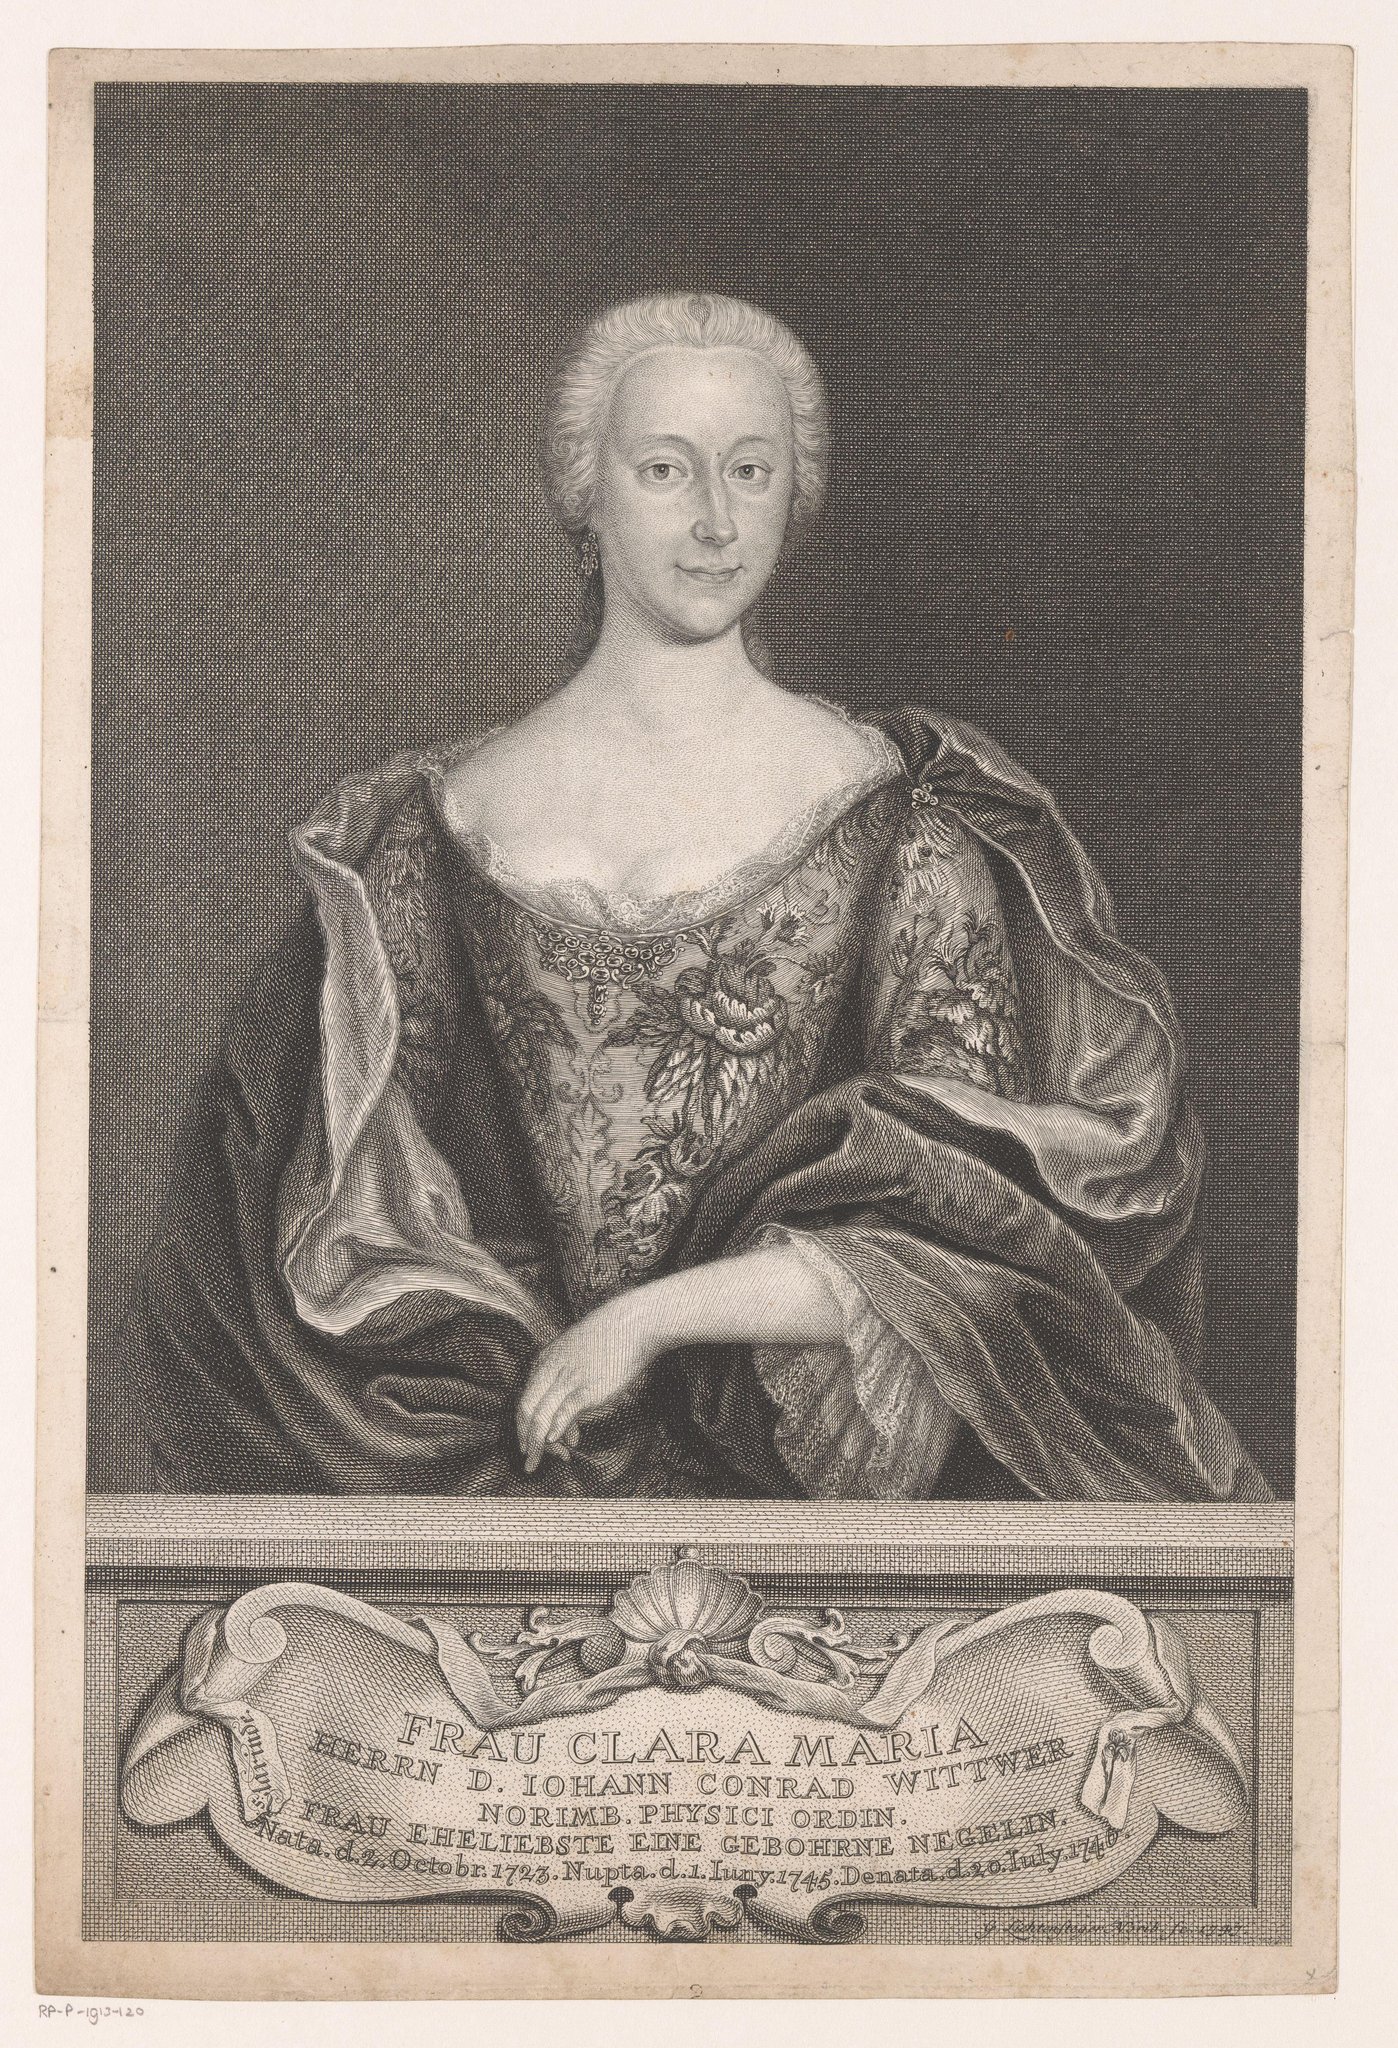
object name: print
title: Portret van Clara Maria Wittwer, geboren Negelein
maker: georg lichtensteger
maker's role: print maker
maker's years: 1700-1781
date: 1747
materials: paper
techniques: engraving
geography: nuremberg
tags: historical persons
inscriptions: collector's mark: Lugt 2228